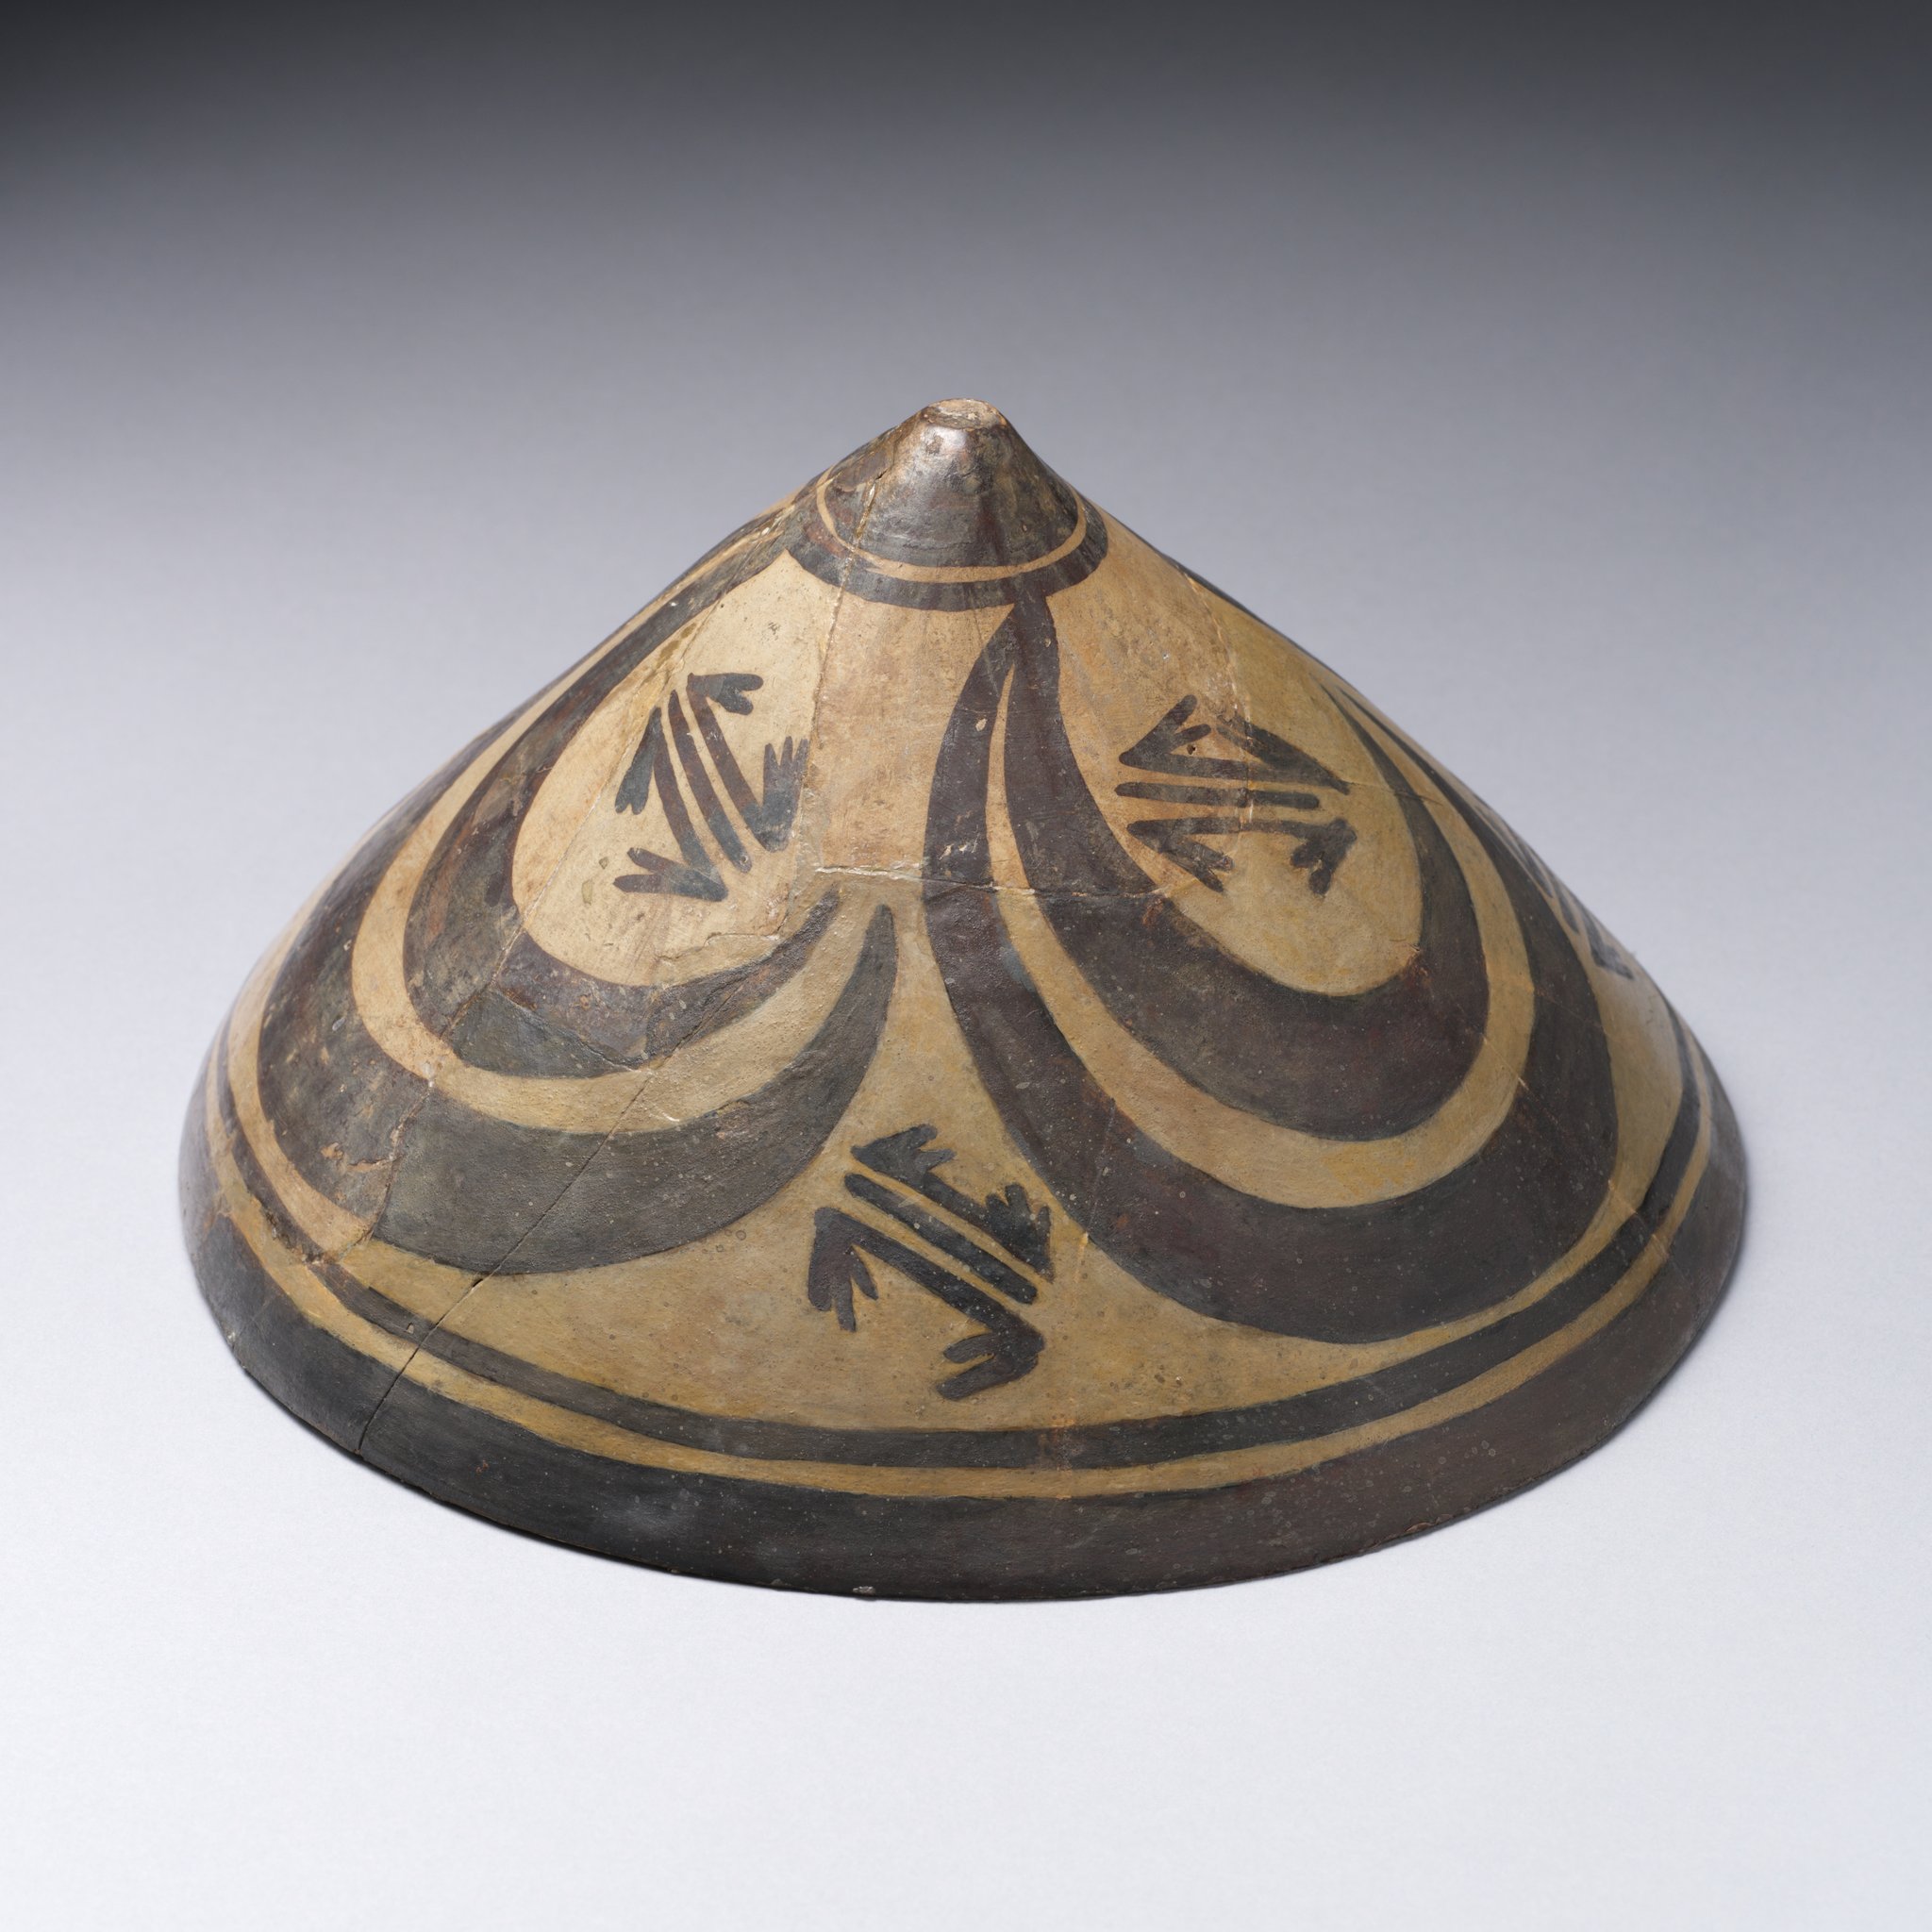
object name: bowl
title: Bowl with radial design of ibex horns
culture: iranian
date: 4500-4100 BCE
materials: ceramic, paint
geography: iran